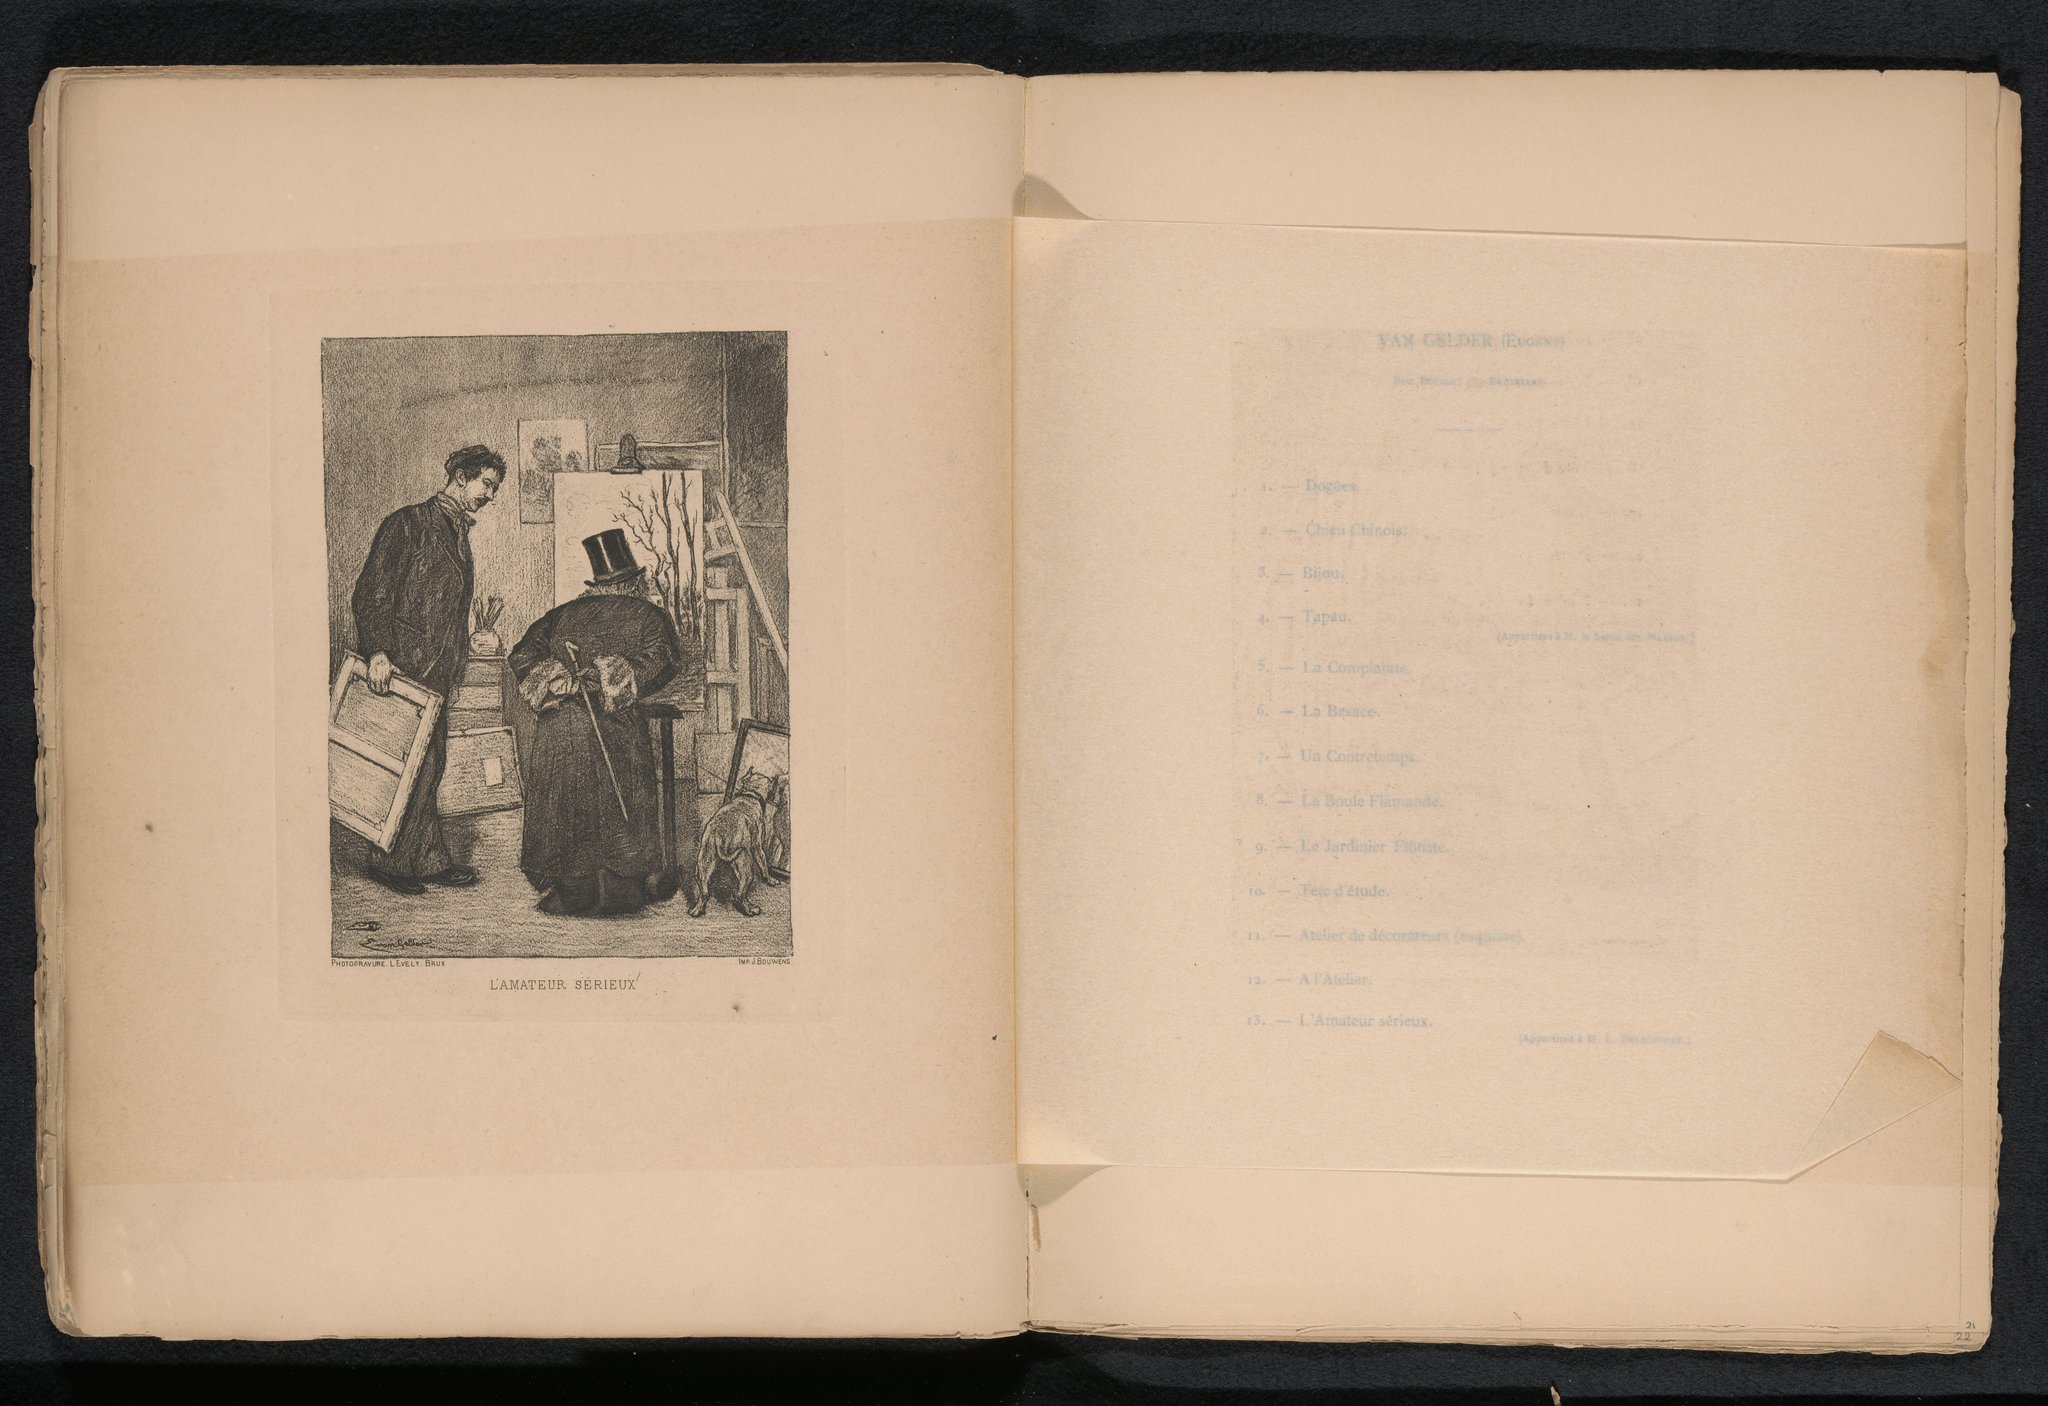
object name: photomechanical print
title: Reproductie van een tekening van een schilder die zijn werk aan iemand toont door Eugène van Gelder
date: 1878-1883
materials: paper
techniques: photoaquatint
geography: brussels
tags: working situations ~ painter